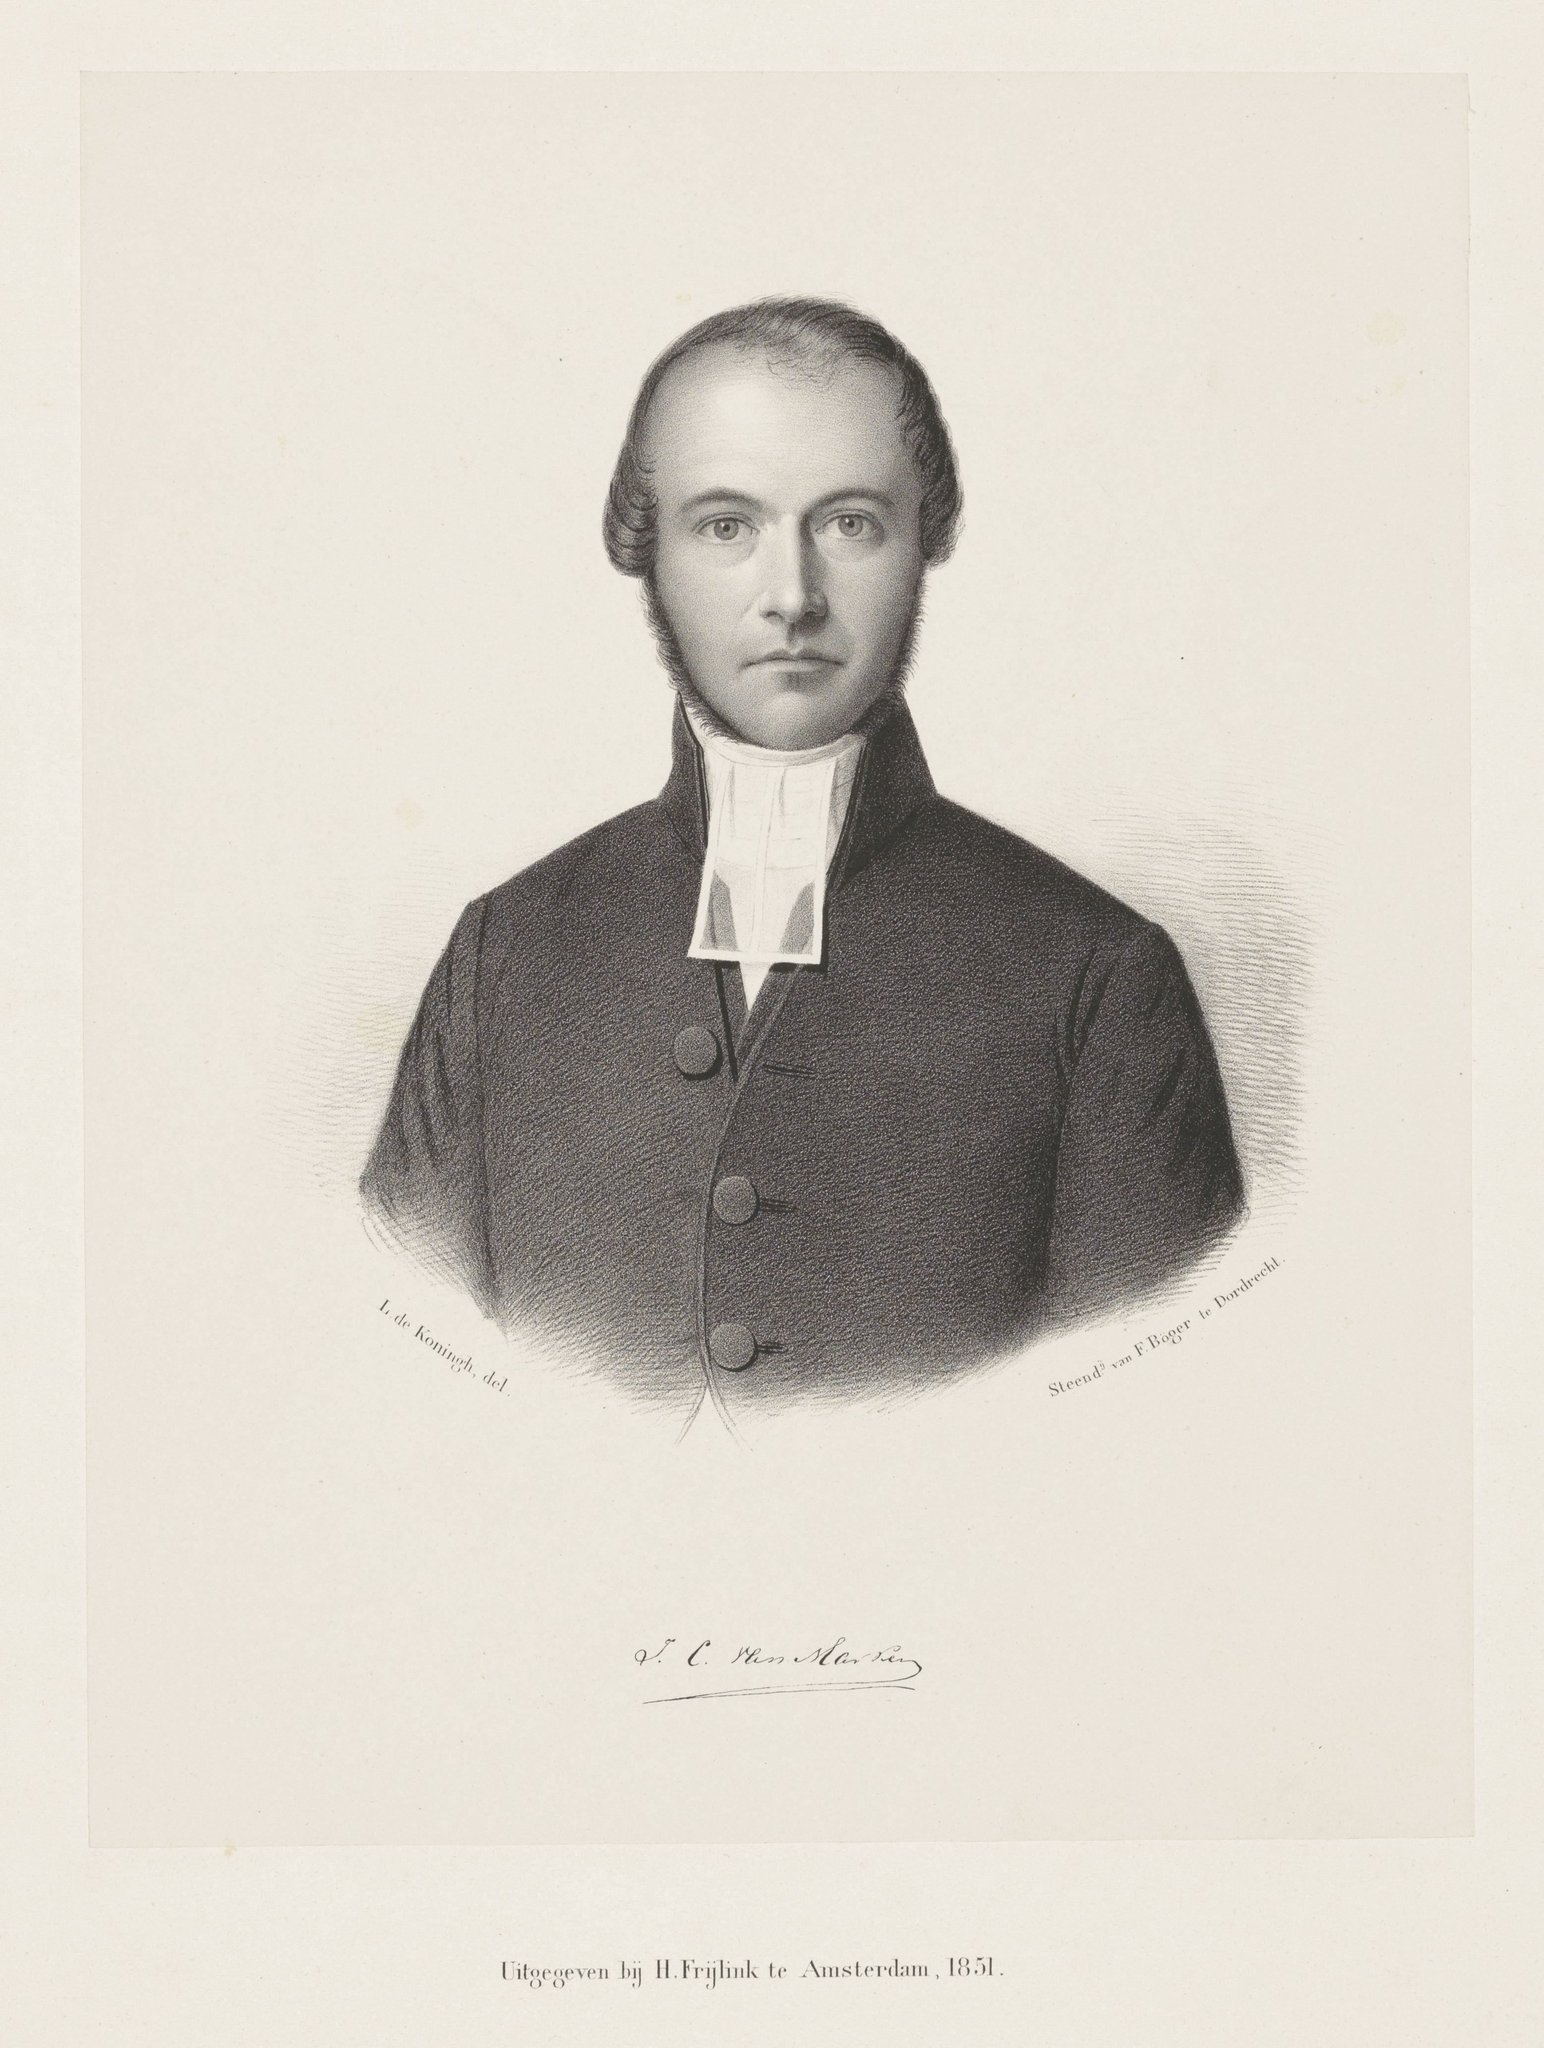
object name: print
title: Portret van Jacob Cornelis van Marken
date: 1851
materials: paper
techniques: lithograph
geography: dordrecht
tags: historical persons (+ (full) bust portrait)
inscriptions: collector's mark: Lugt 2228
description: Onder het portret de signatuur van de geportretteerde.